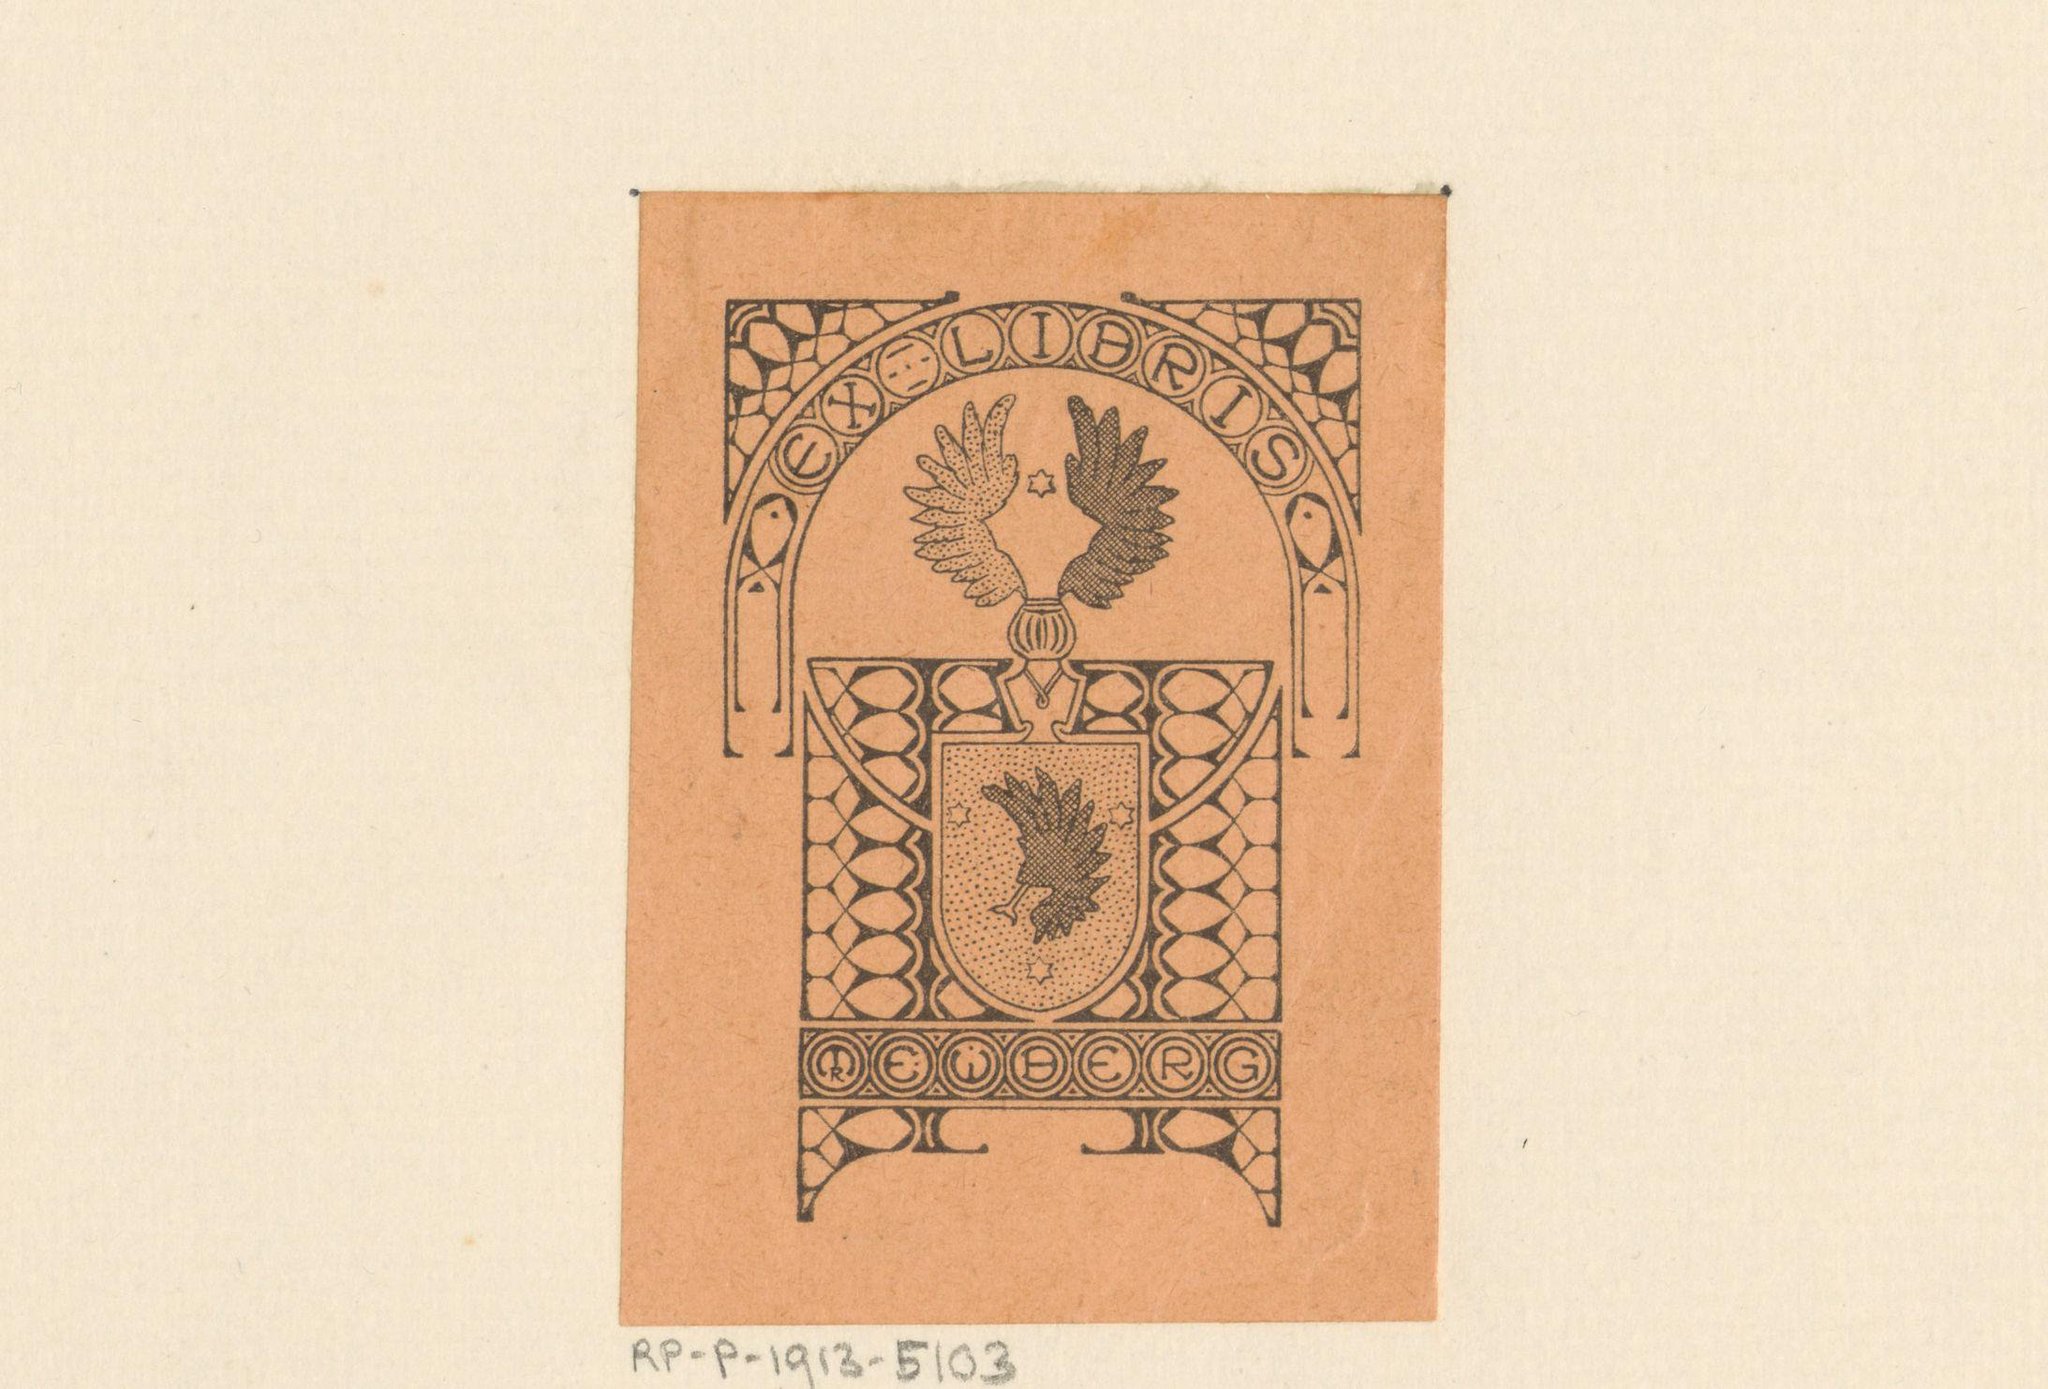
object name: bookplate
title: Ex libris van M.E.W. Berg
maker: Anonymous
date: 1890-1913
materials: paper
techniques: printing block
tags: armorial bearing, heraldry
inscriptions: collector's mark: Lugt 2233, collector's mark: Lugt 2760